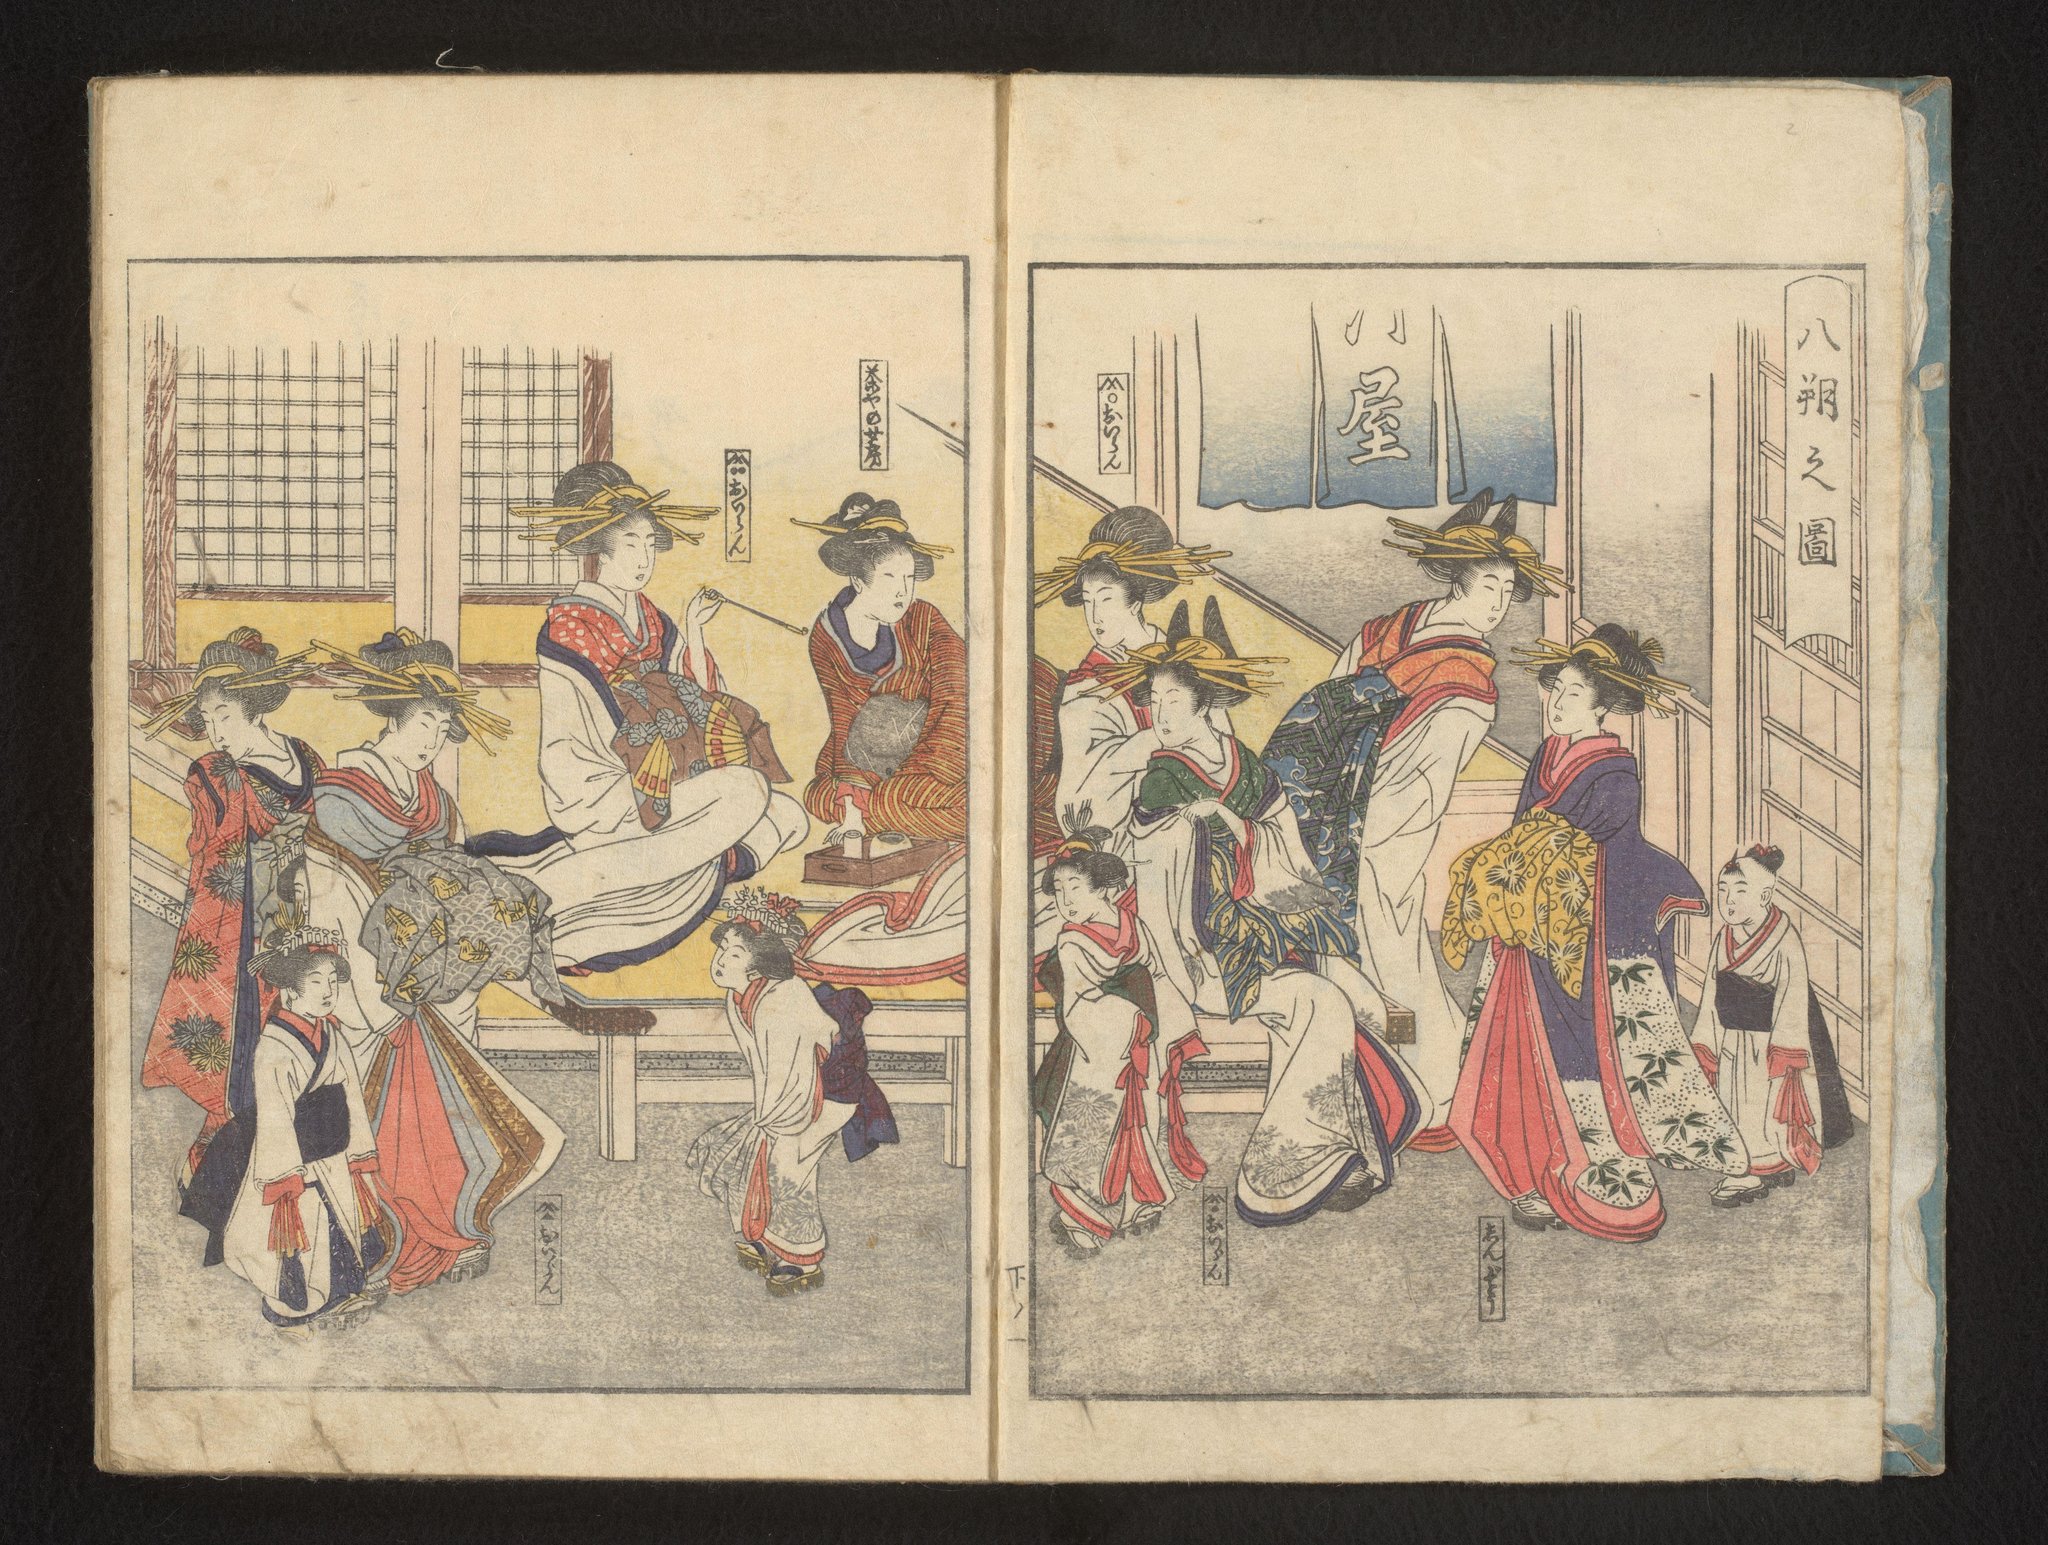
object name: page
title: Courtisanes in een kamer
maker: kitagawa utamaro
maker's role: print maker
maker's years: 1753-1806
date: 1804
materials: paper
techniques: woodcut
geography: edo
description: Tweede en derde pagina van deel twee van Utamaro`s boek: Gebeurtenissen in de lusthuizen gedurende het jaar.